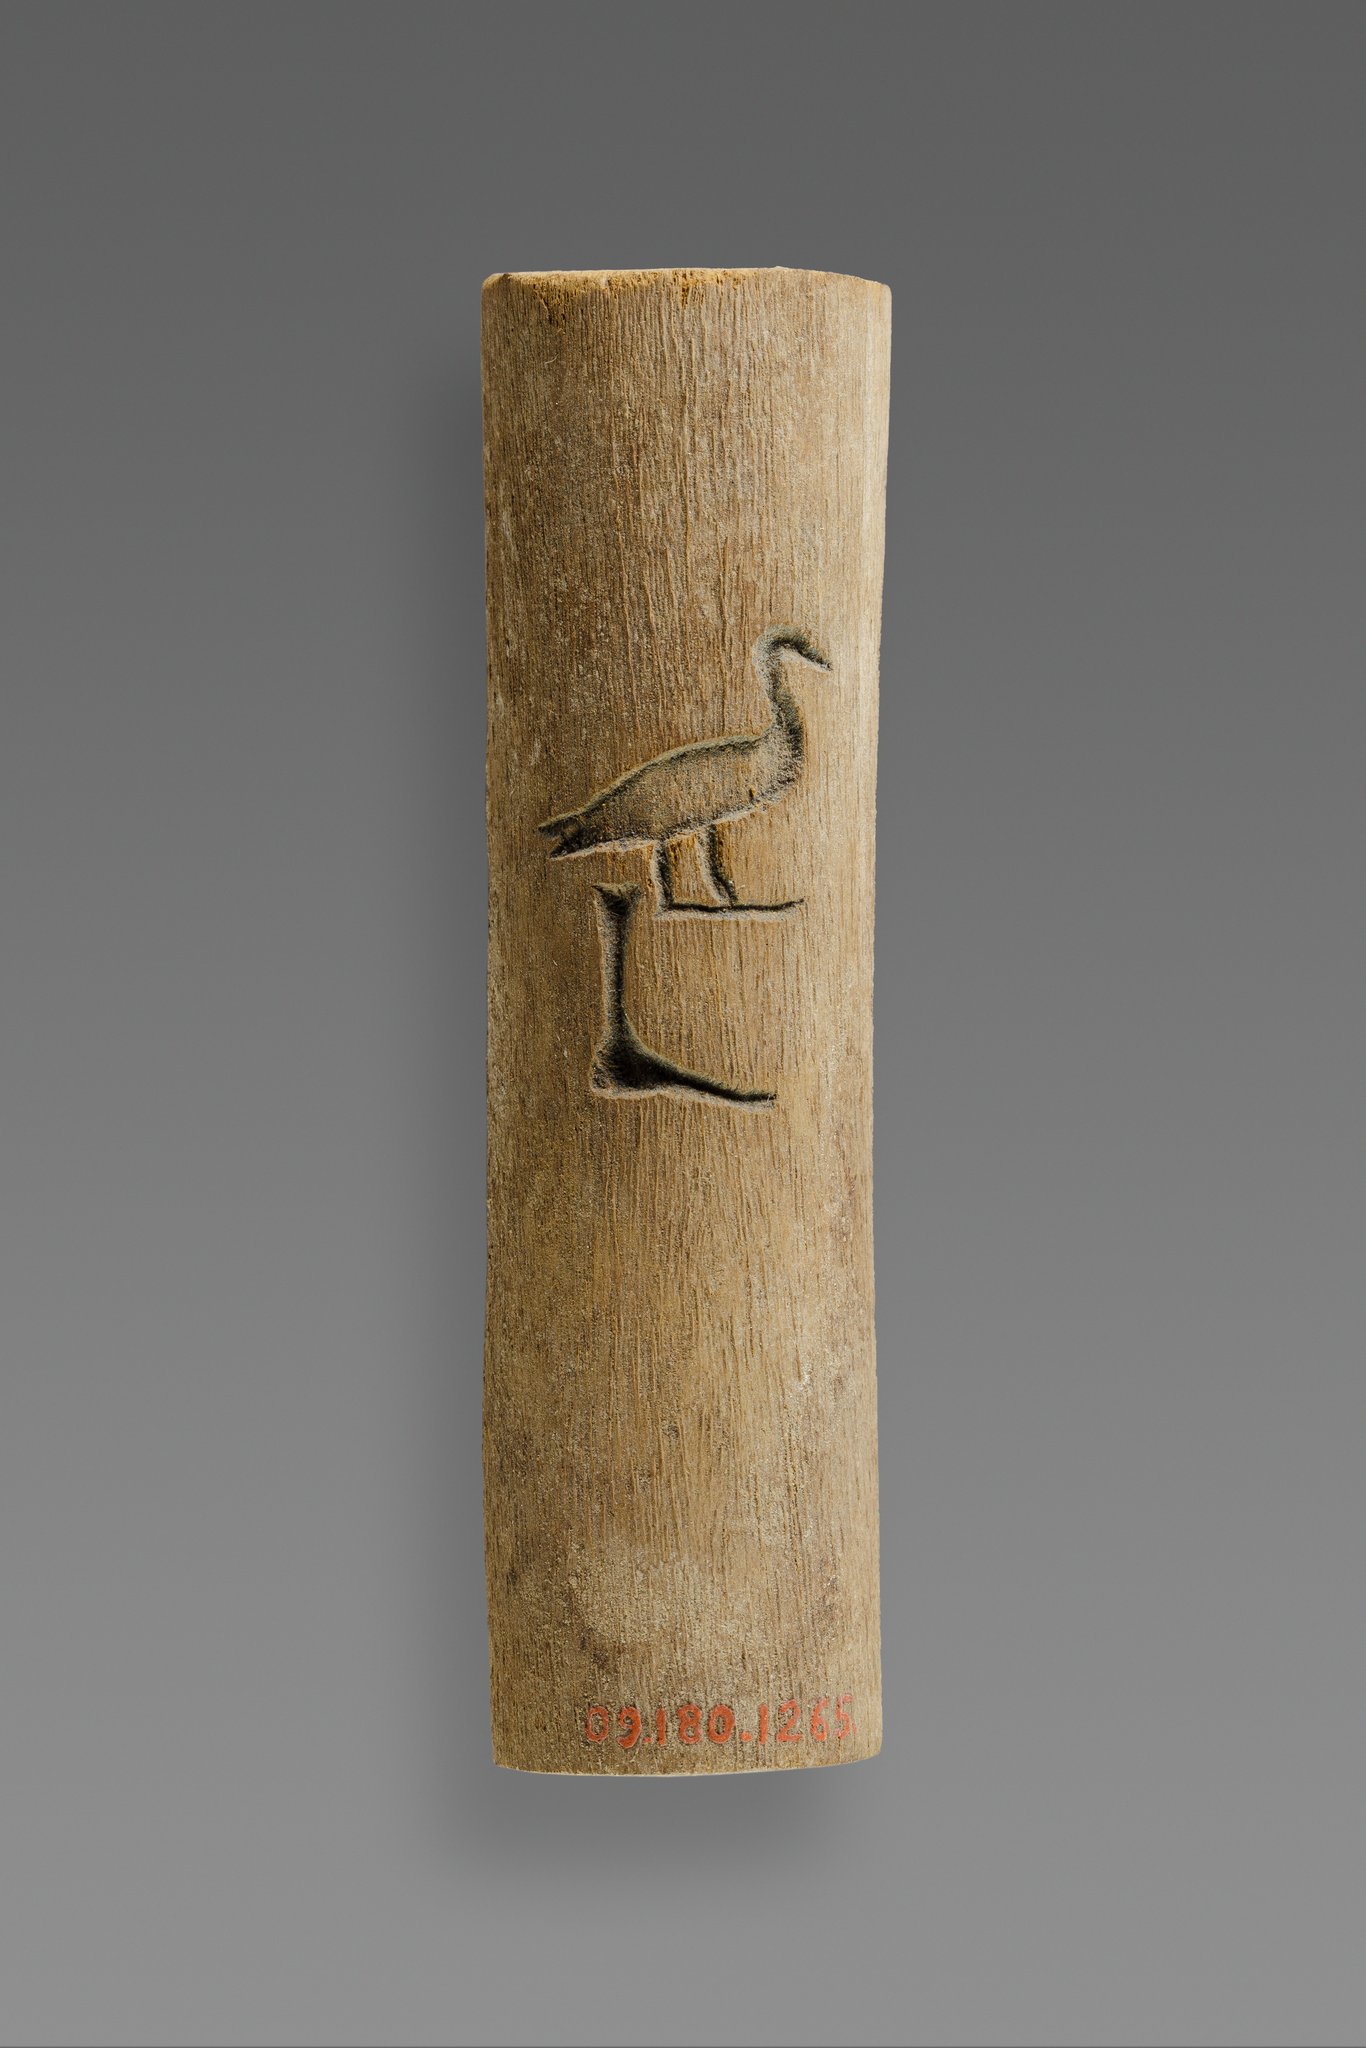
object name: cylinder, from a ceremonial whip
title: Cylinder, perhaps from a ceremonial whip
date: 1981-1802 BCE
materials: paste, wood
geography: egypt